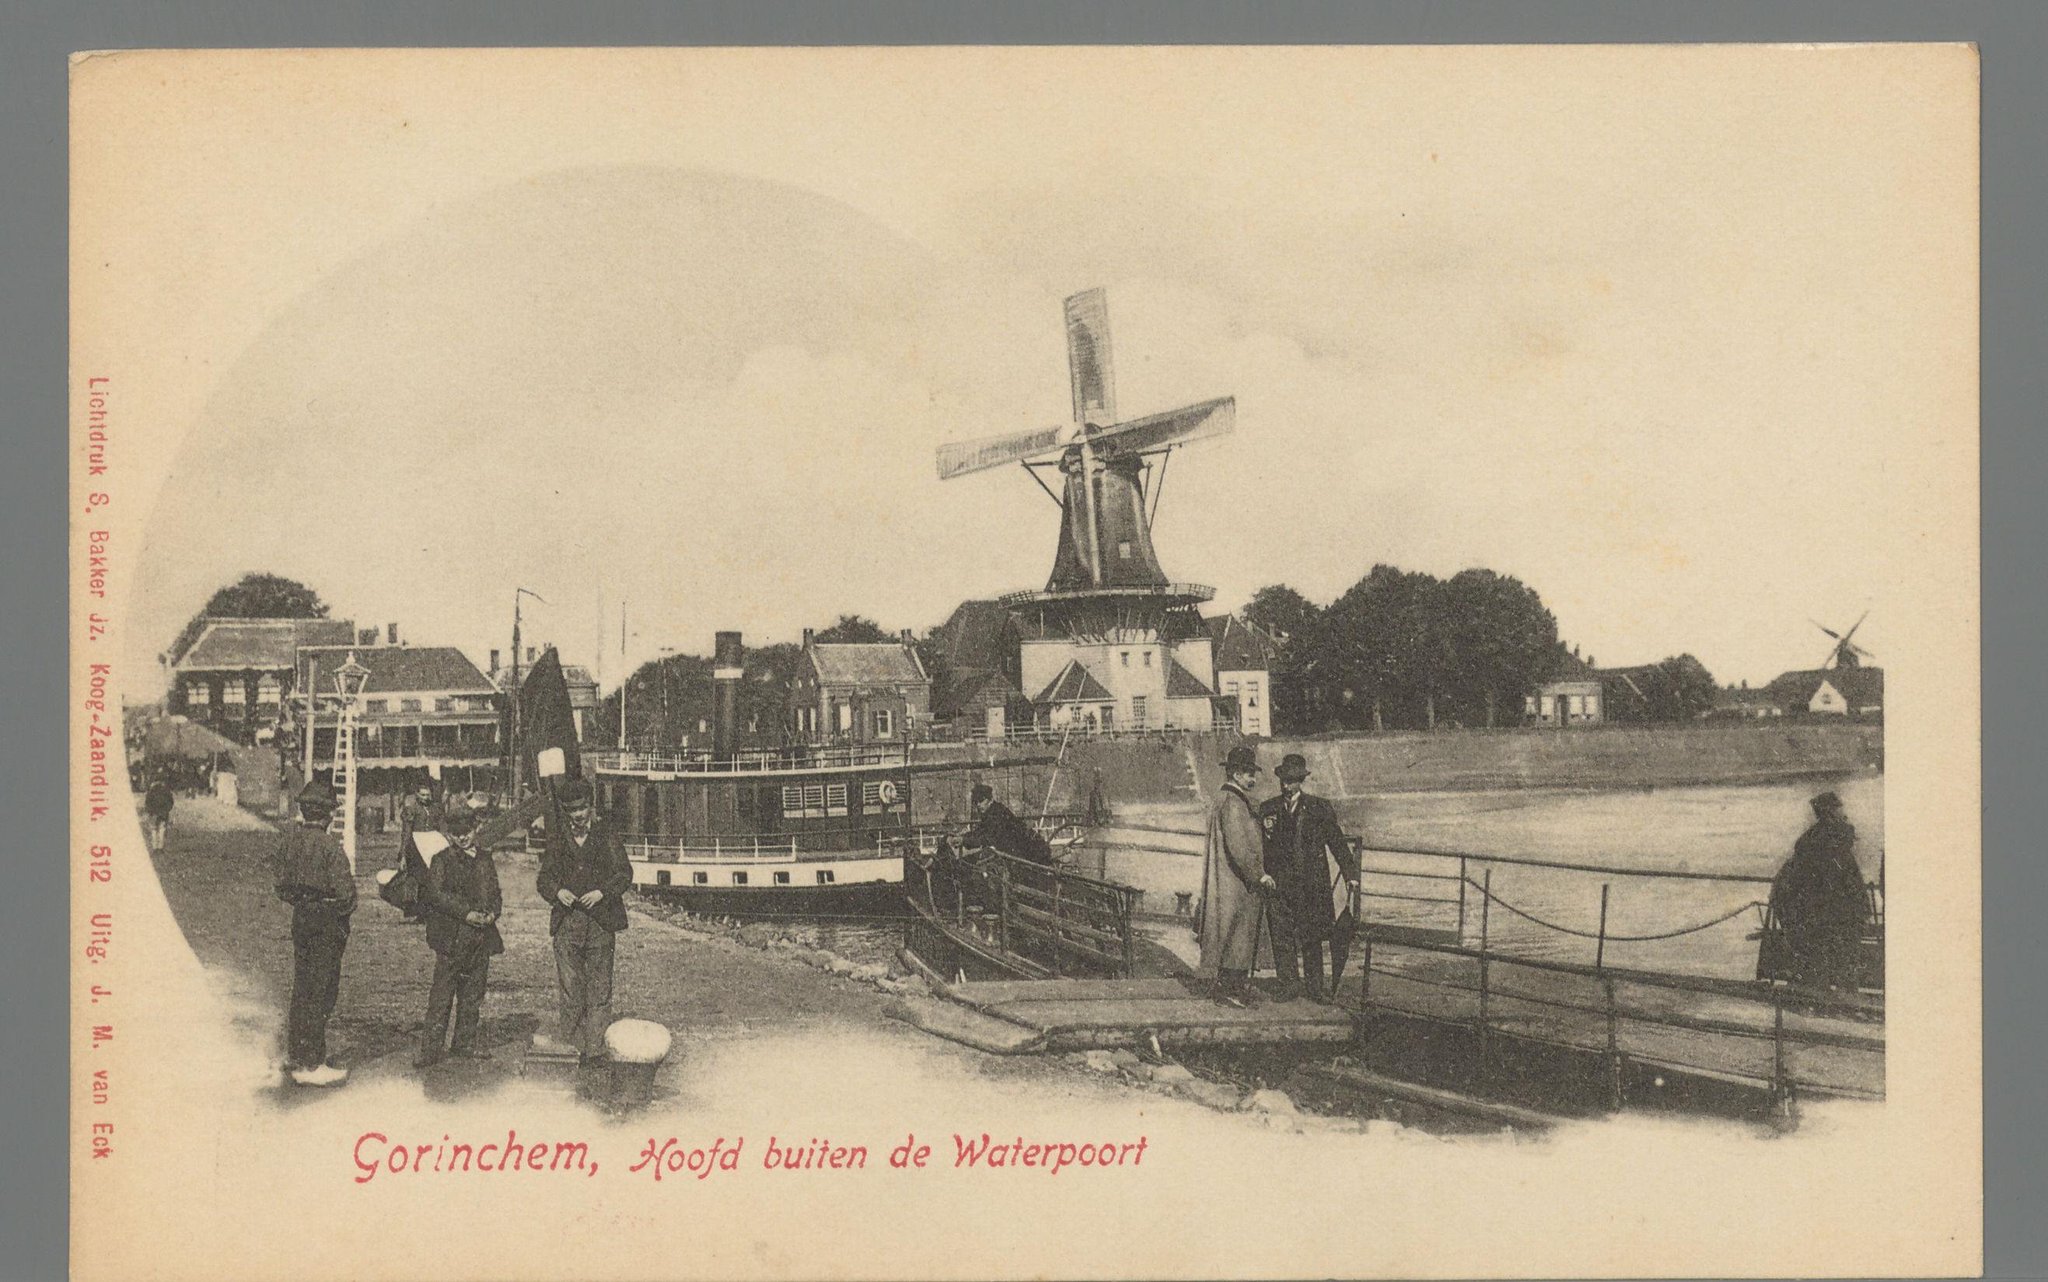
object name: ansichtkaart, prentbriefkaart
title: Gorinchem, hoofd buiten de Waterpoort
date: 1899-1905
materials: cardboard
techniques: photograph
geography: koog aan de zaan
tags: harbour, city-view, and landscape with man-made constructions, windmill